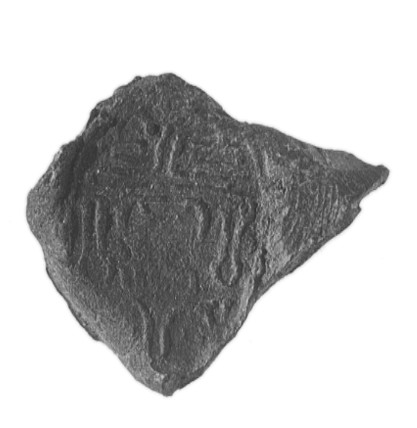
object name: sealing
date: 2030-1640 BCE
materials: clay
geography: egypt